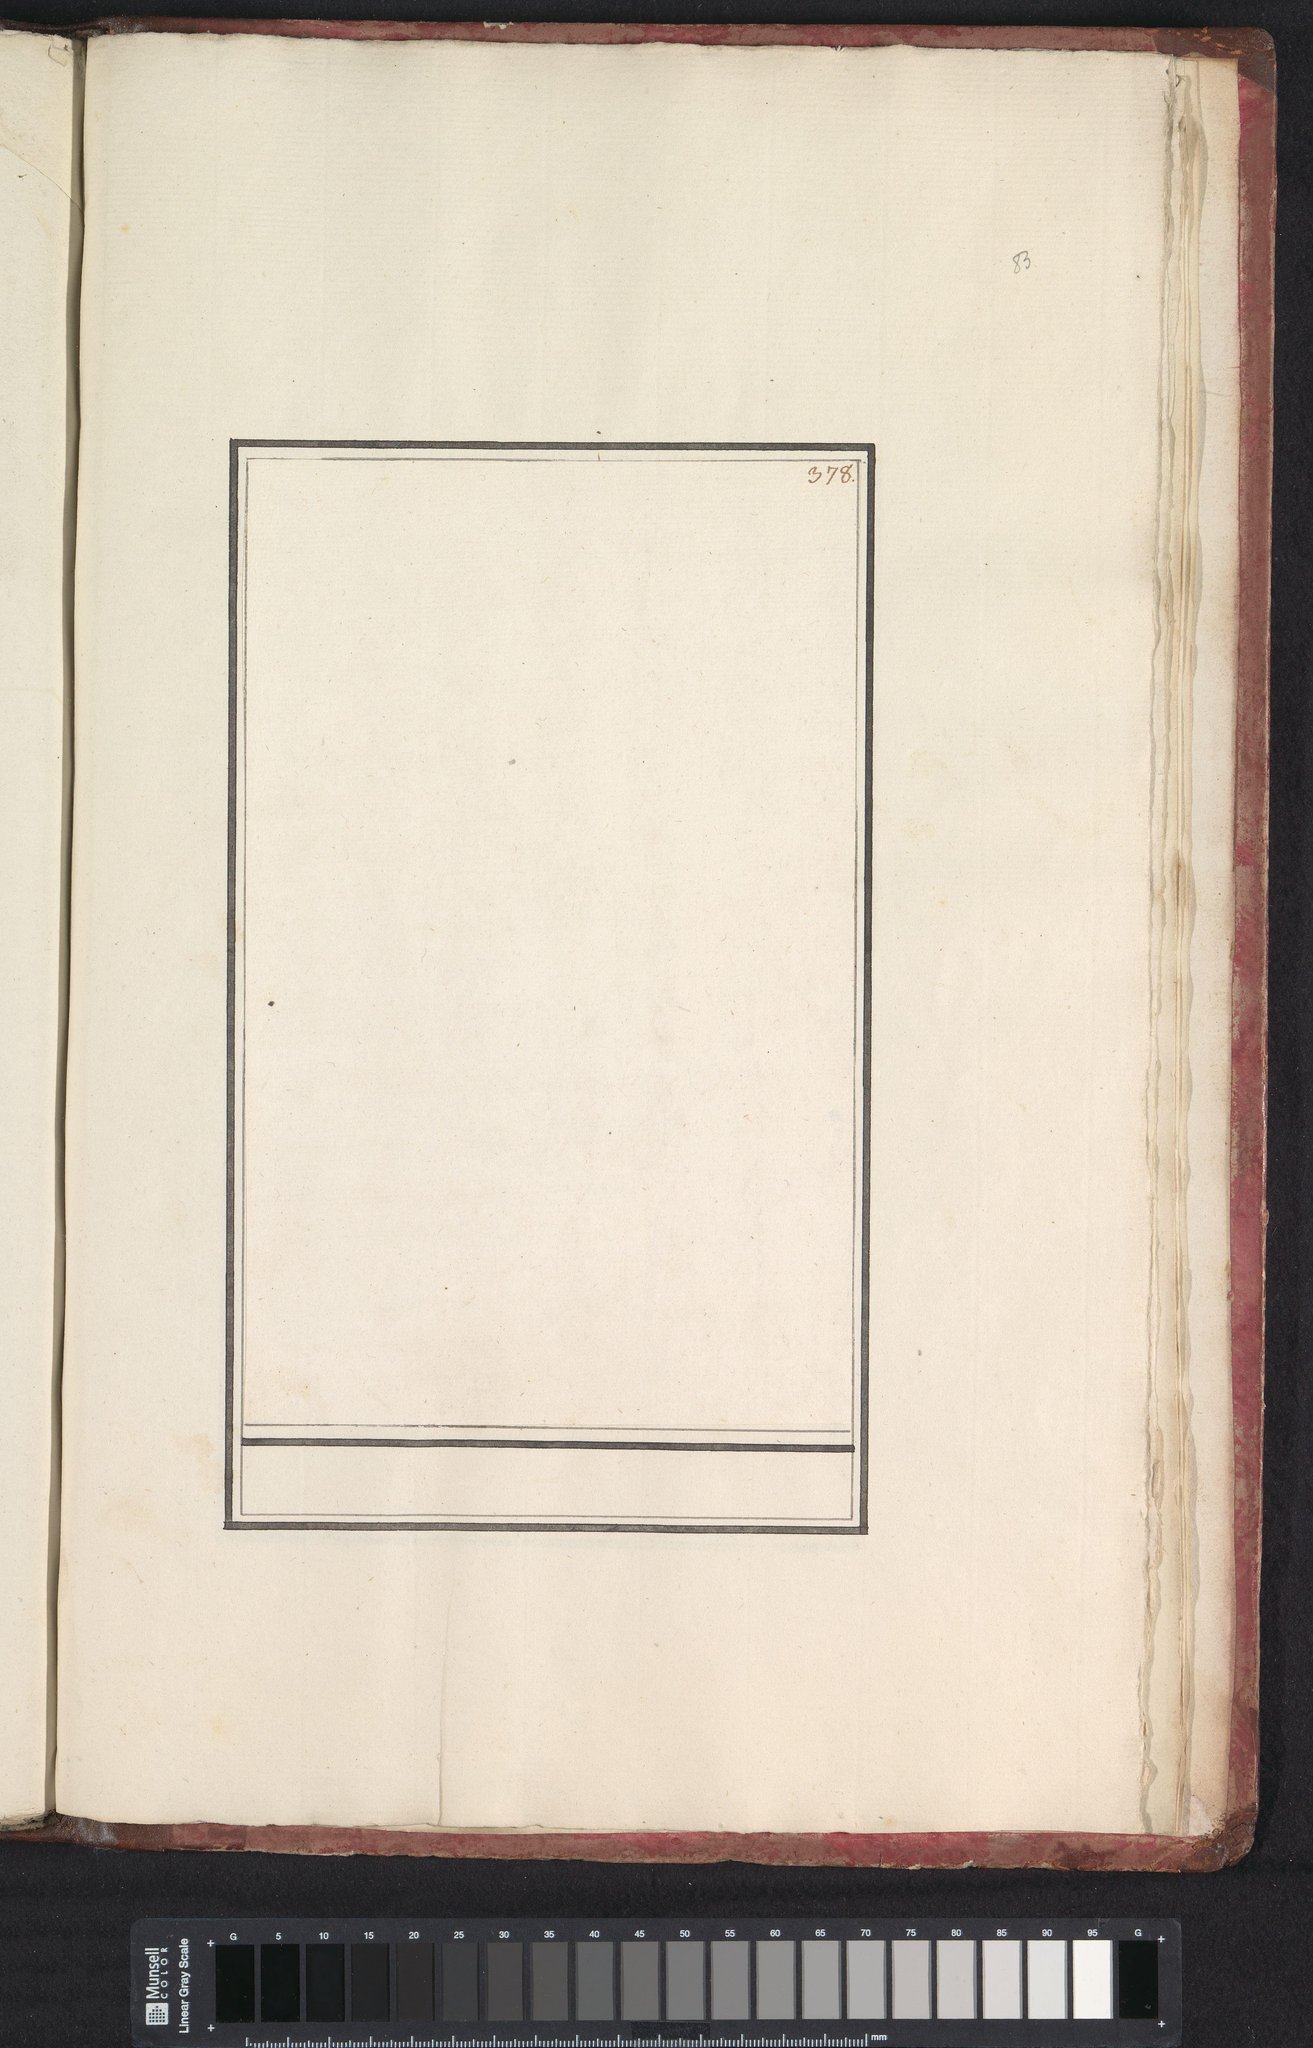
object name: drawing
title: Omlijsting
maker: Anonymous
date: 1809-1814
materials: paper, pencil, watercolor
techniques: brush, pen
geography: southern netherlands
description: Lege omlijsting. Rechtsboven genummerd: 378. Onderdeel van het vierde album met tekeningen van bloemen en paddestoelen. Elfde van twaalf albums met tekeningen van dieren, vogels en planten bekend rond 1600, gemaakt in opdracht van keizer Rudolf II. Met toelichting in Nederlands, Latijn en Frans.